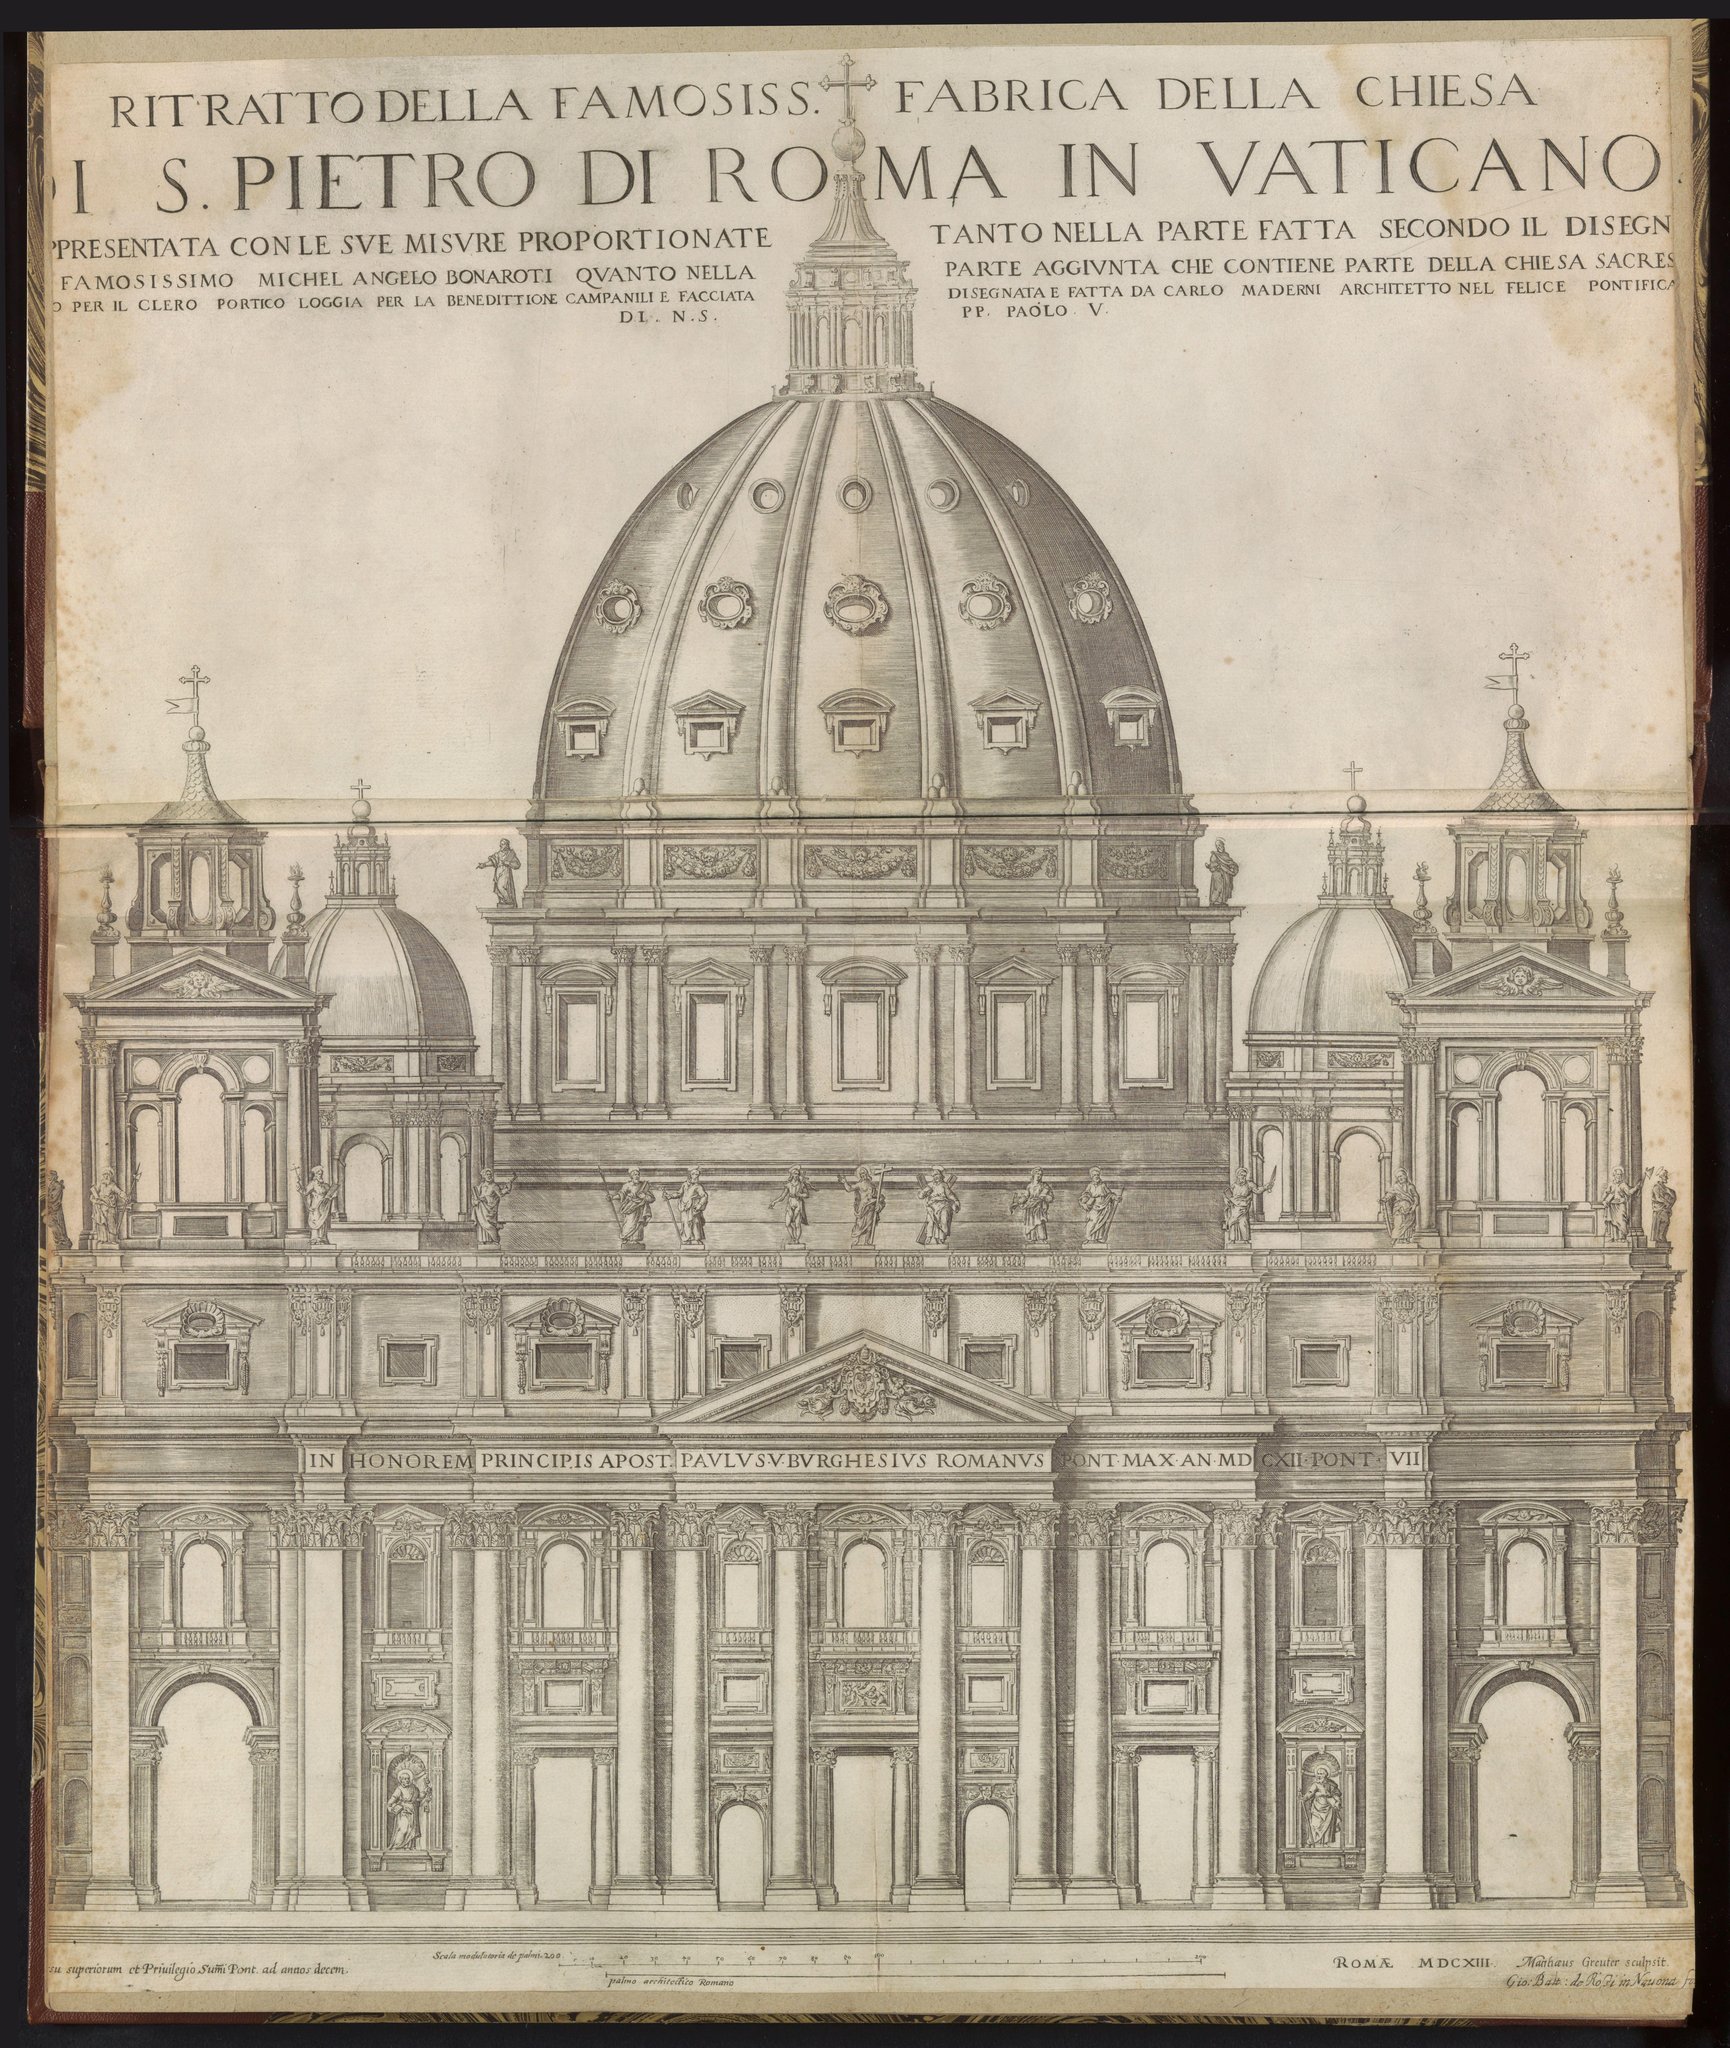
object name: print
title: Ritratto della famosiss. fabrica della chiesa di S. Pietro di Roma in Vatican (...)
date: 1613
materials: paper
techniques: etching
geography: rome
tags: church (exterior), roman catholic church, parts of church exterior and annexes: façade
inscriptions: date